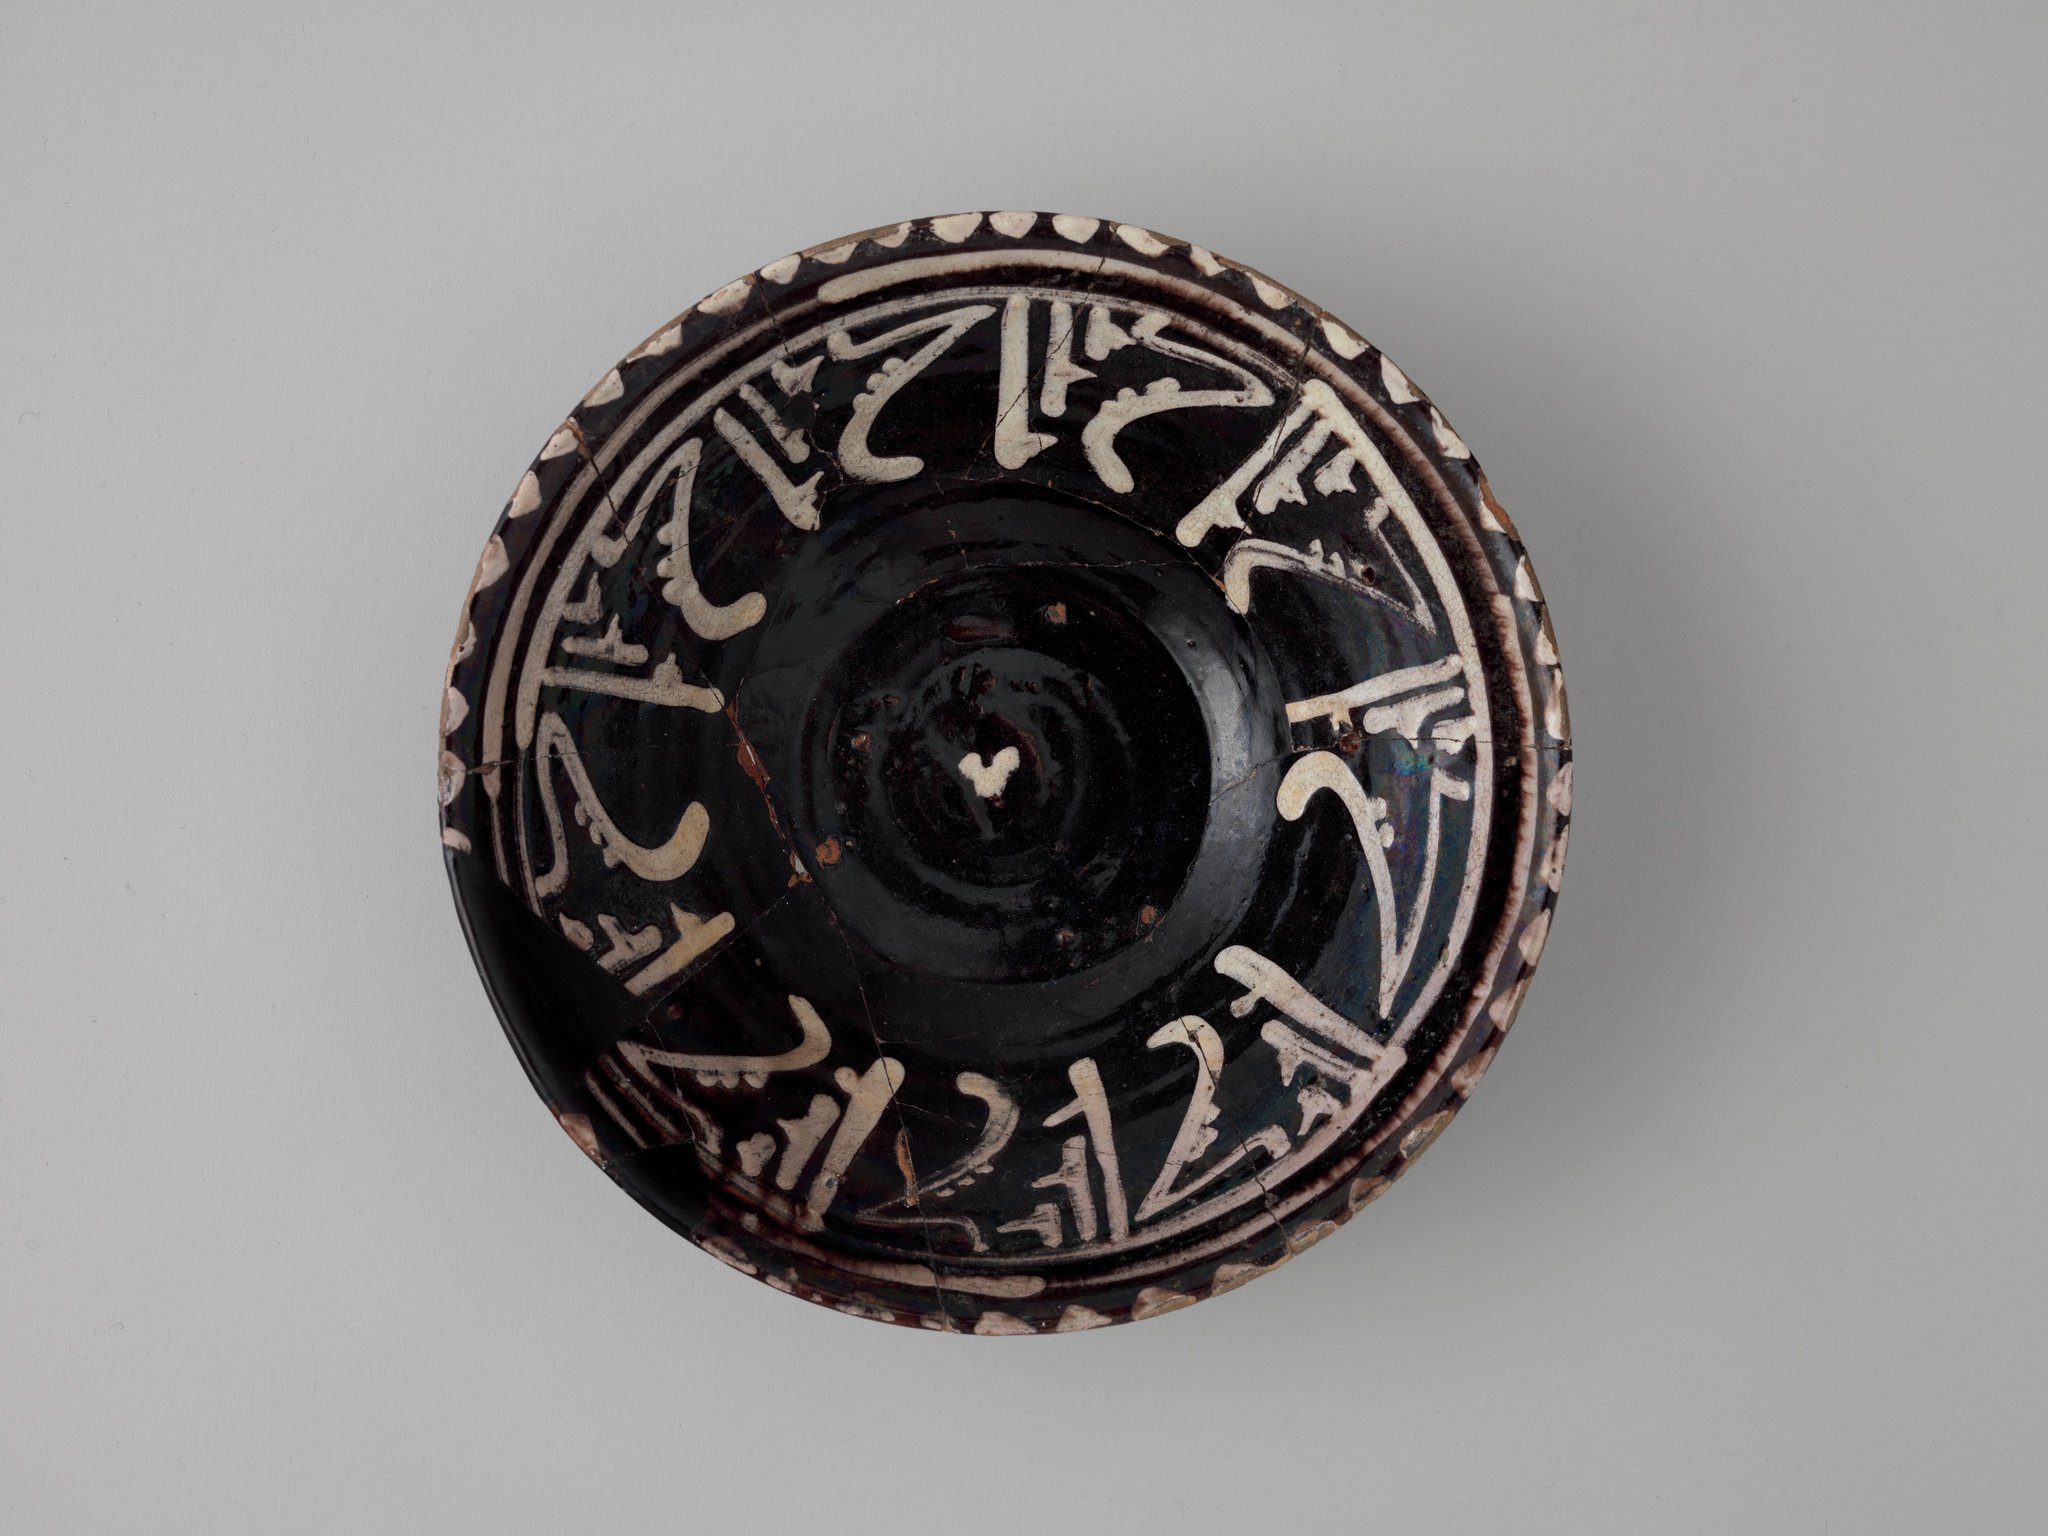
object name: bowl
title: Bowls with Repeating Inscription, "Blessing"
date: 867-933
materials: earthenware, glaze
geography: iran